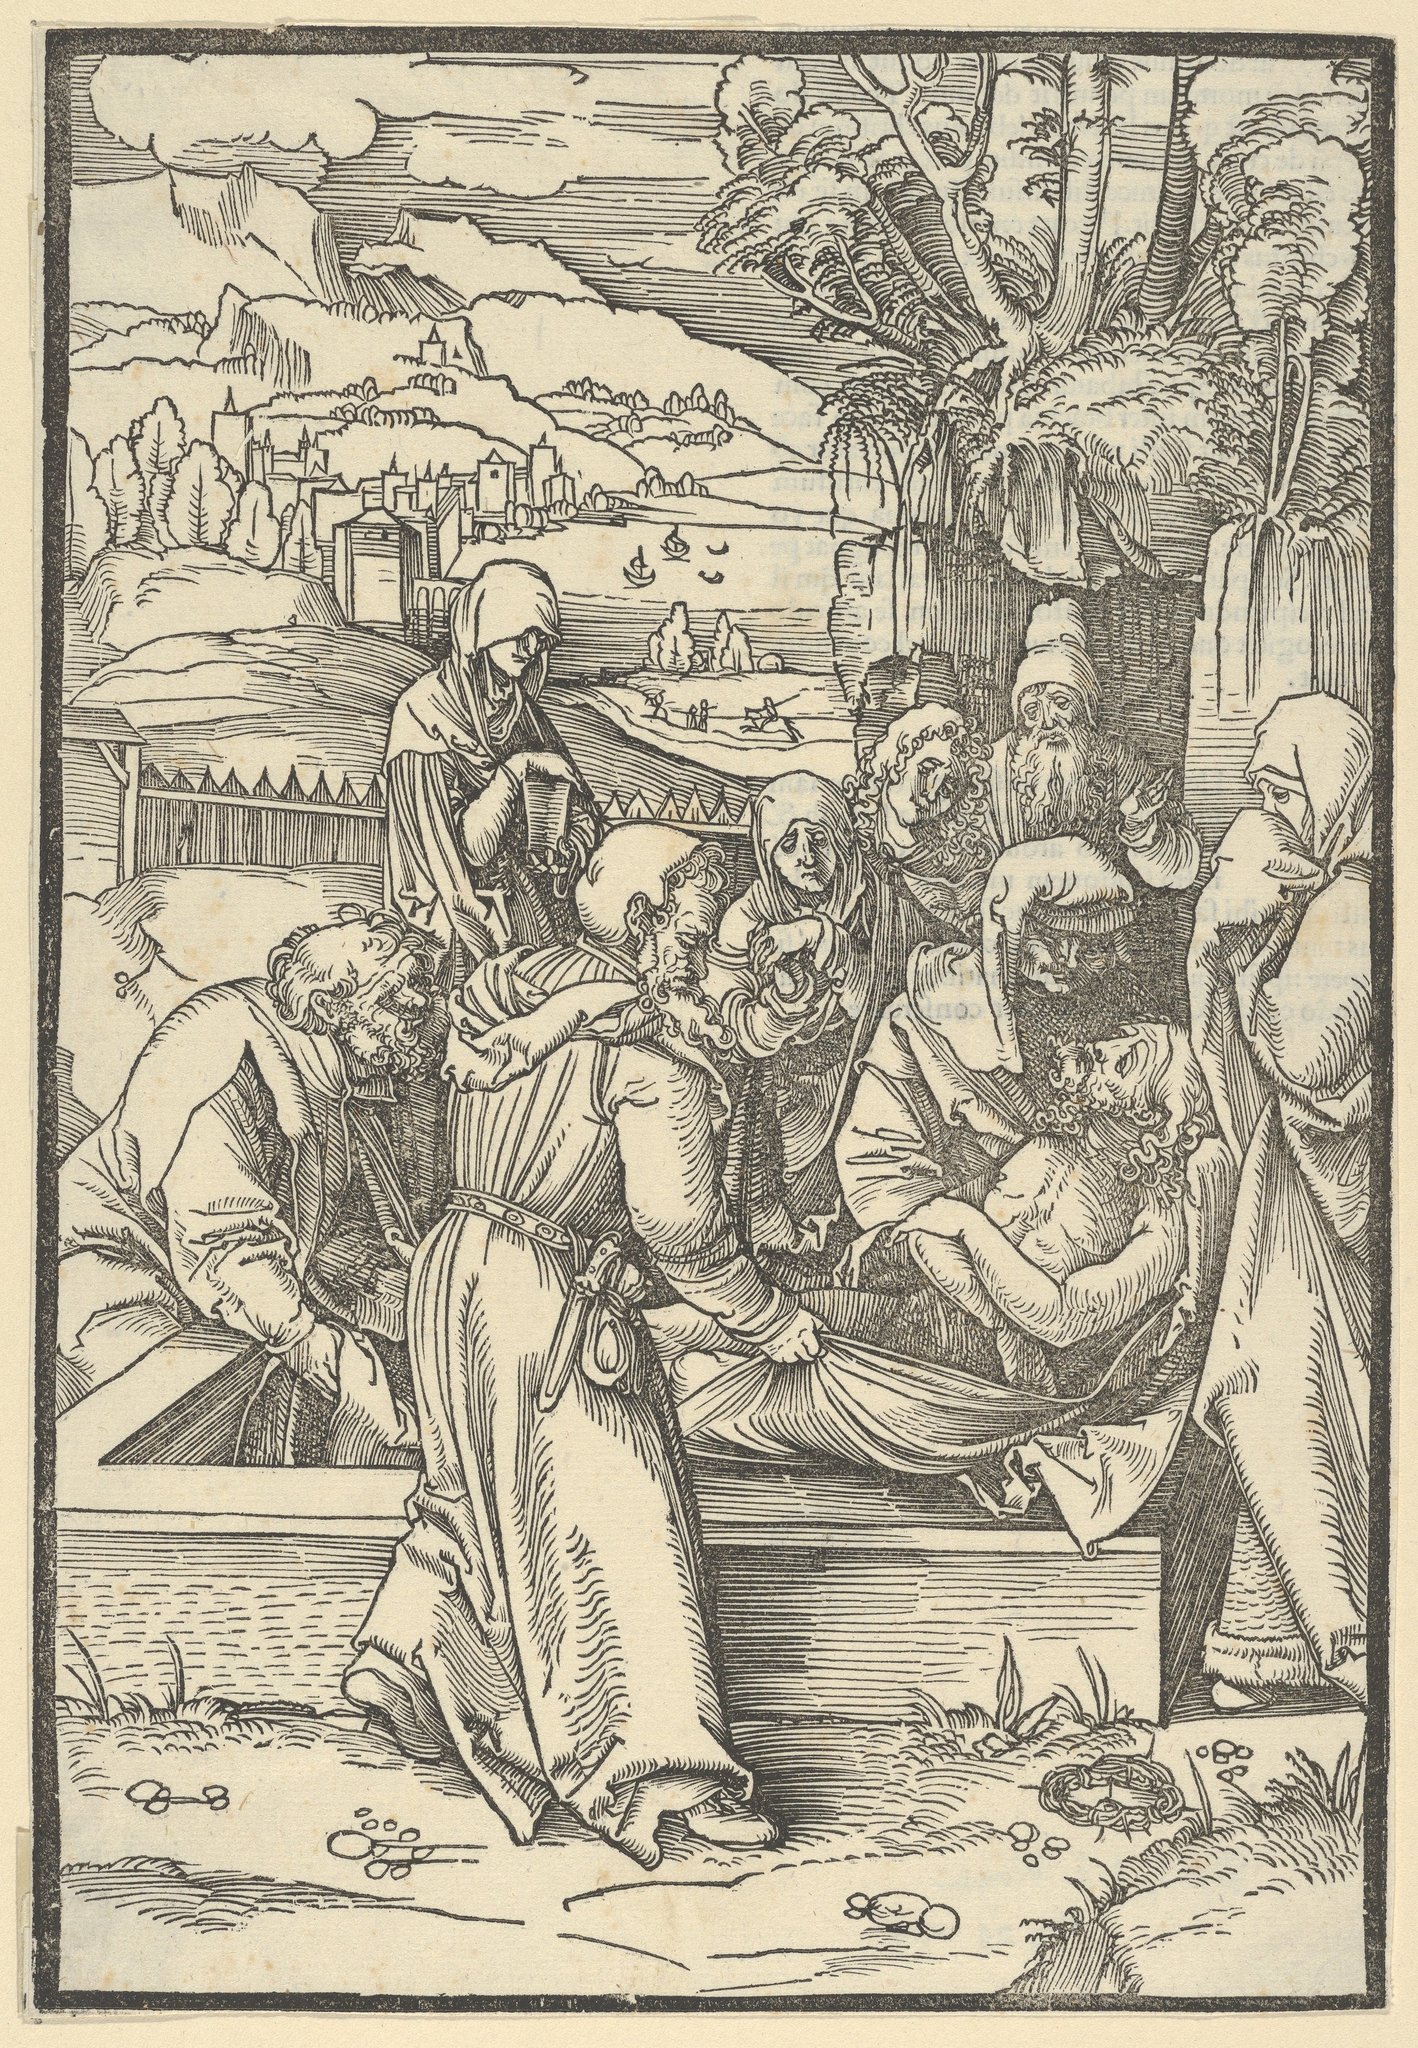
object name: print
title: The Entombment, from Speculum passionis domini nostri Ihesu Christi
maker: hans schäufelein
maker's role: artist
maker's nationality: german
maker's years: 1480-1540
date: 1507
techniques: woodcut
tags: christ,mary magdalene,virgin mary,entombment